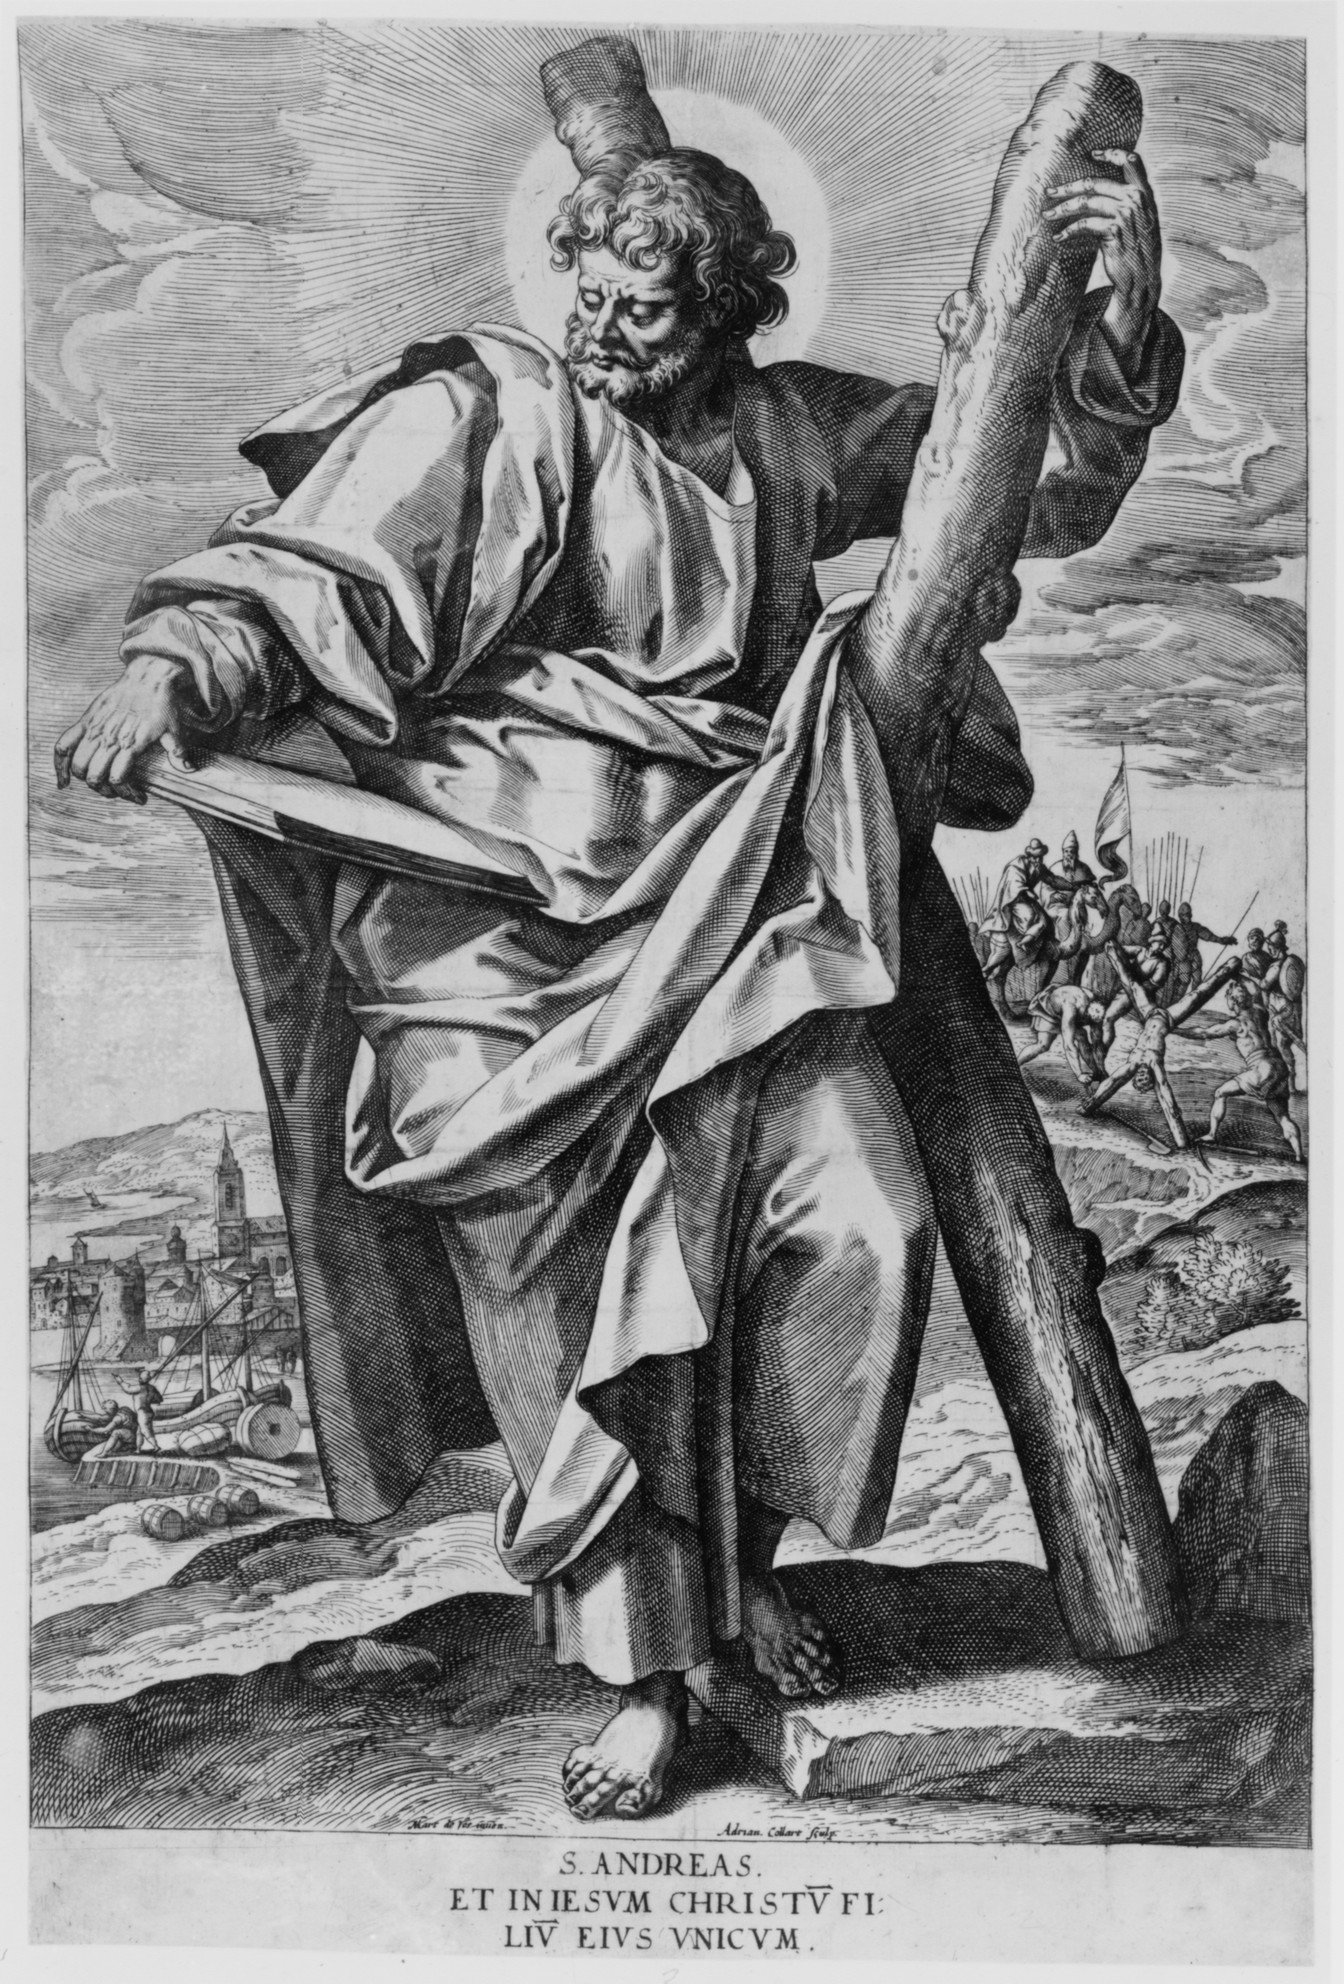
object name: print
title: Christ and the Twelve Apostles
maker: maerten de vos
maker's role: artist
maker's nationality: netherlandish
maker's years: 1532-1603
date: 1592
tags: christ